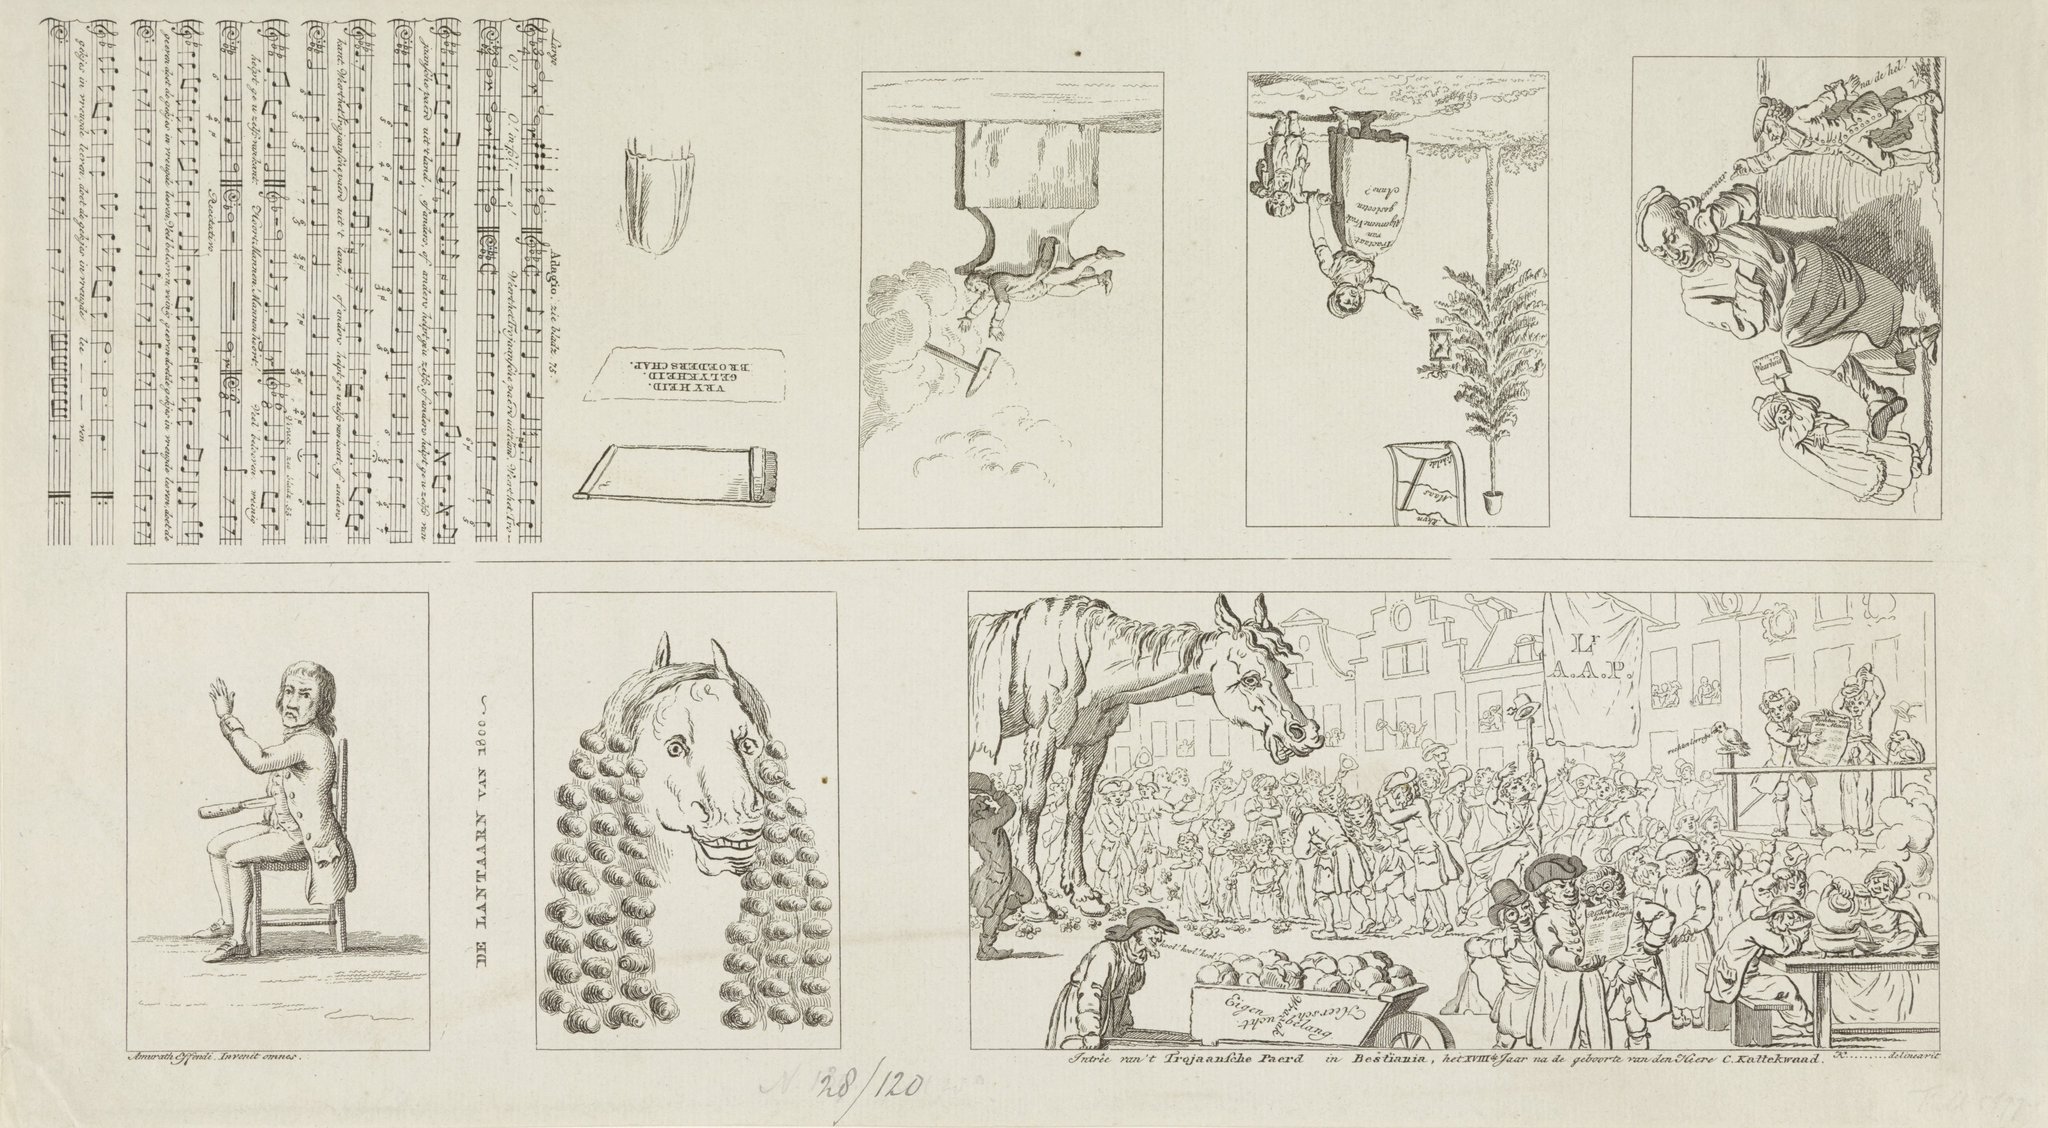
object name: print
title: Blad met illustraties voor: De Lantaarn van 1800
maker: pieter van woensel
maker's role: print maker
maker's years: 1747-1808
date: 1799-1800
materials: paper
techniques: etching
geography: netherlands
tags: franse tijd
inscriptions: collector's mark: Lugt 2228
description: Een reusachtig uitgemergeld paard wordt ingehaald onder het gejuich van een menigte. Kinderen strooien bloemen. Op een estrade worden 'De Rechten van de Mensch'aan het volk getoond. Op de voorgrond een man met kruiwagen met kool, waaronder de woorden: Vrijheid, Gelijkheid, Broederschap en daaronder: Heerschzucht, Eigenbelang, Wraak.